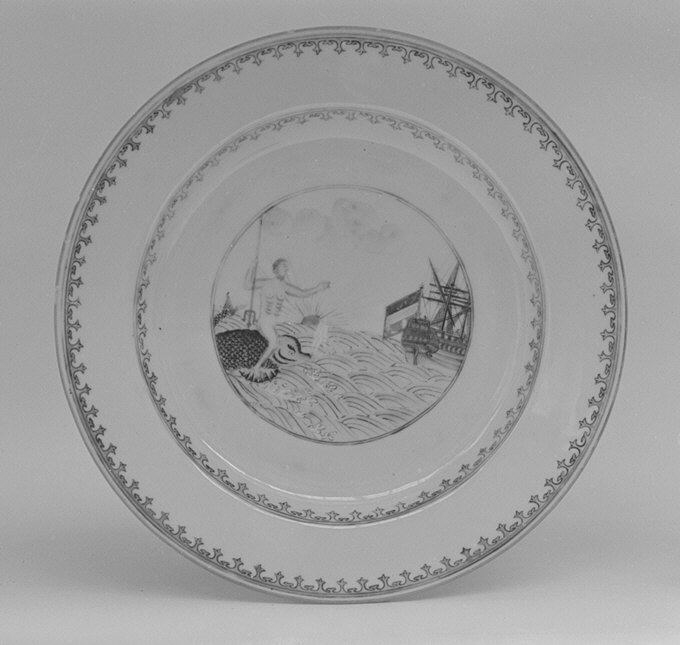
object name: plate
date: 1750-1770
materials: hard paste porcelain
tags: men,dolphins,ships